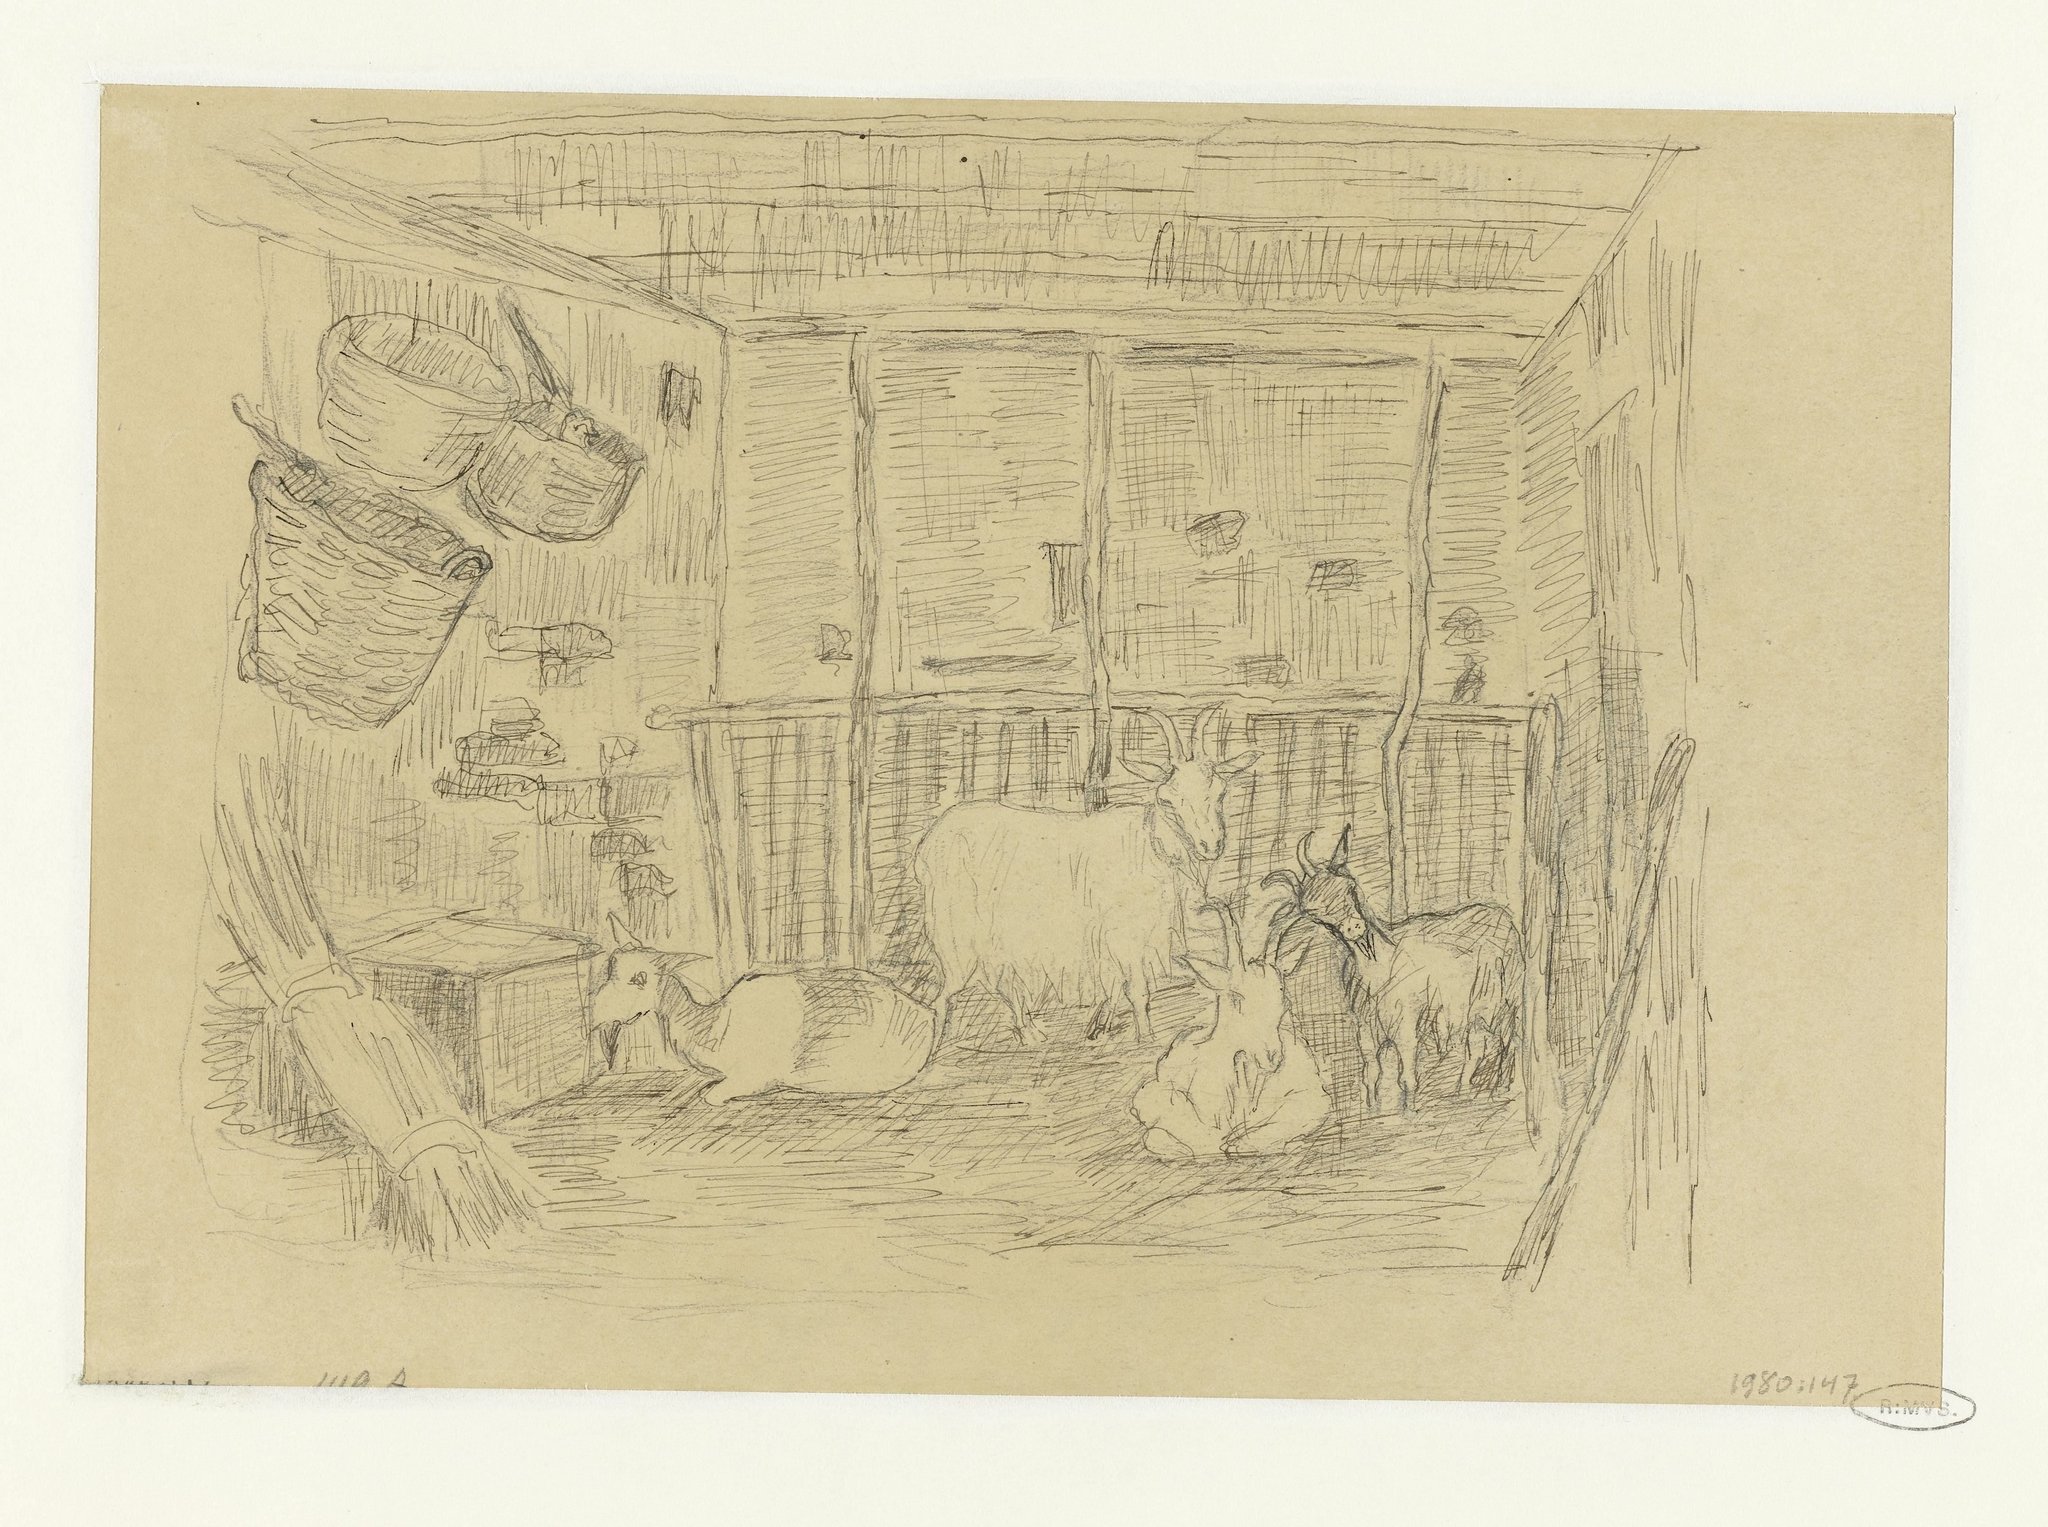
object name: drawing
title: Interieur van een stal met geiten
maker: jozef israëls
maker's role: draughtsman, painter, print maker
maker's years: 1824-1911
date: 1834-1911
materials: ink, paper, pencil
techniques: pen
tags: barn - aa - civic architecture: inside, goat